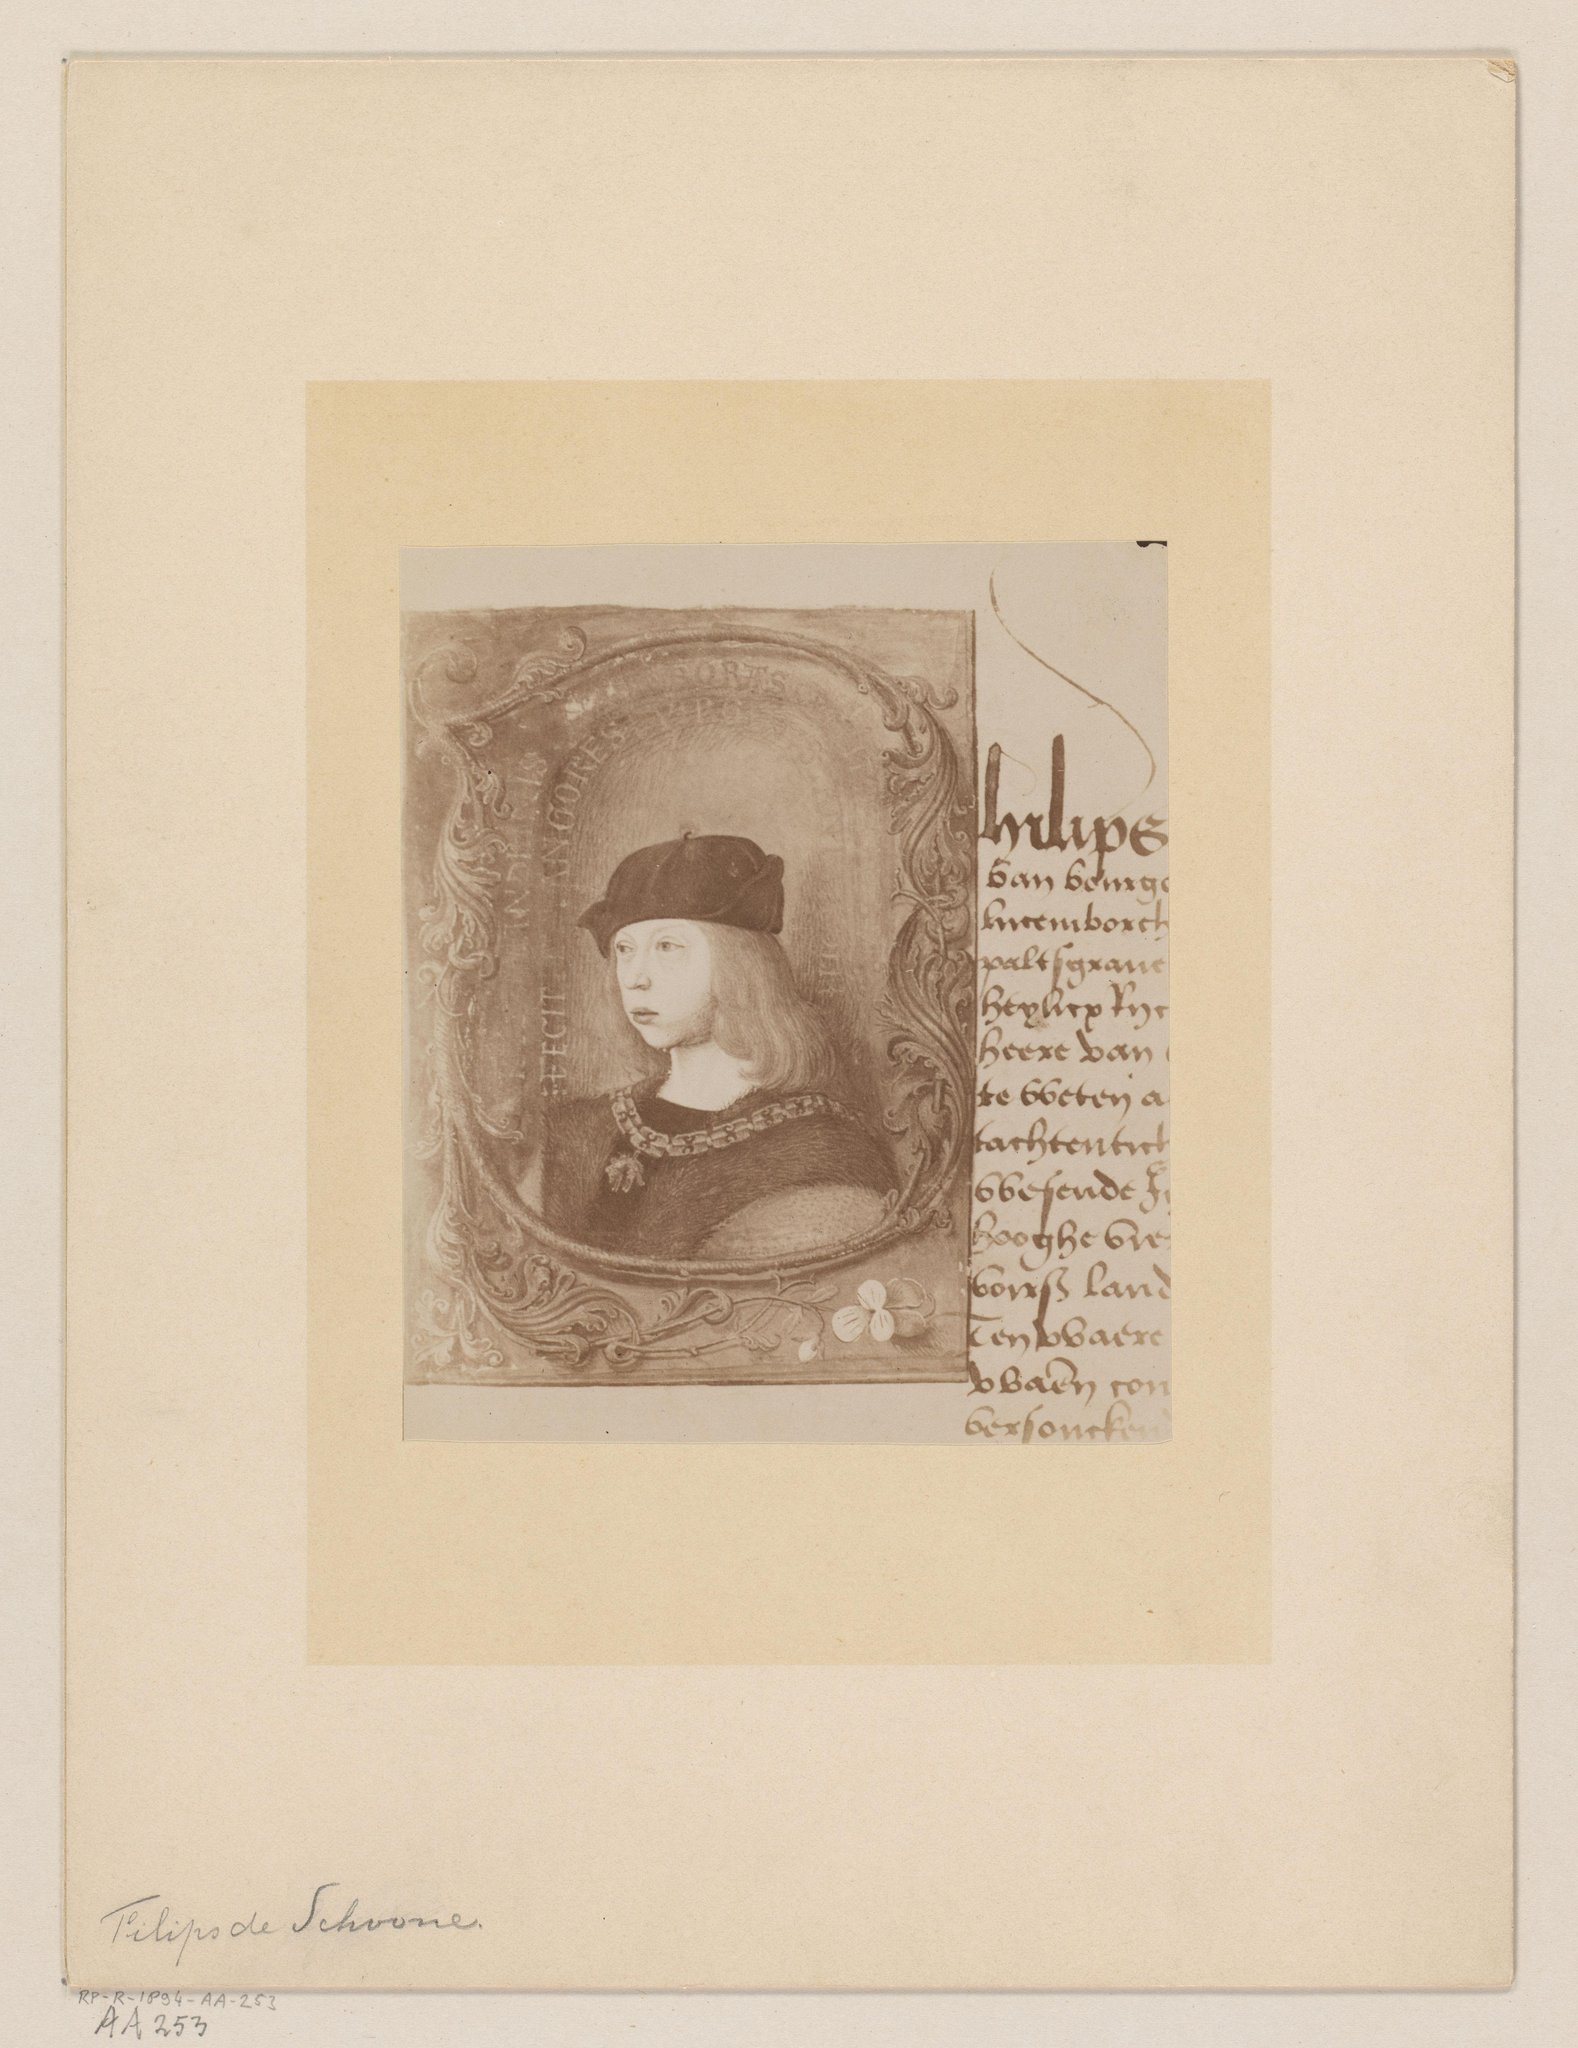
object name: reproduction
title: Fotoreproductie van een geschilderd portret van Filips I van Castilië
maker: Anonymous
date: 1860-1894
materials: cardboard, paper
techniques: albumen print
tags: filips de schone (hertog van bourgondië), historical persons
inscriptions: collector's mark: Lugt 2228